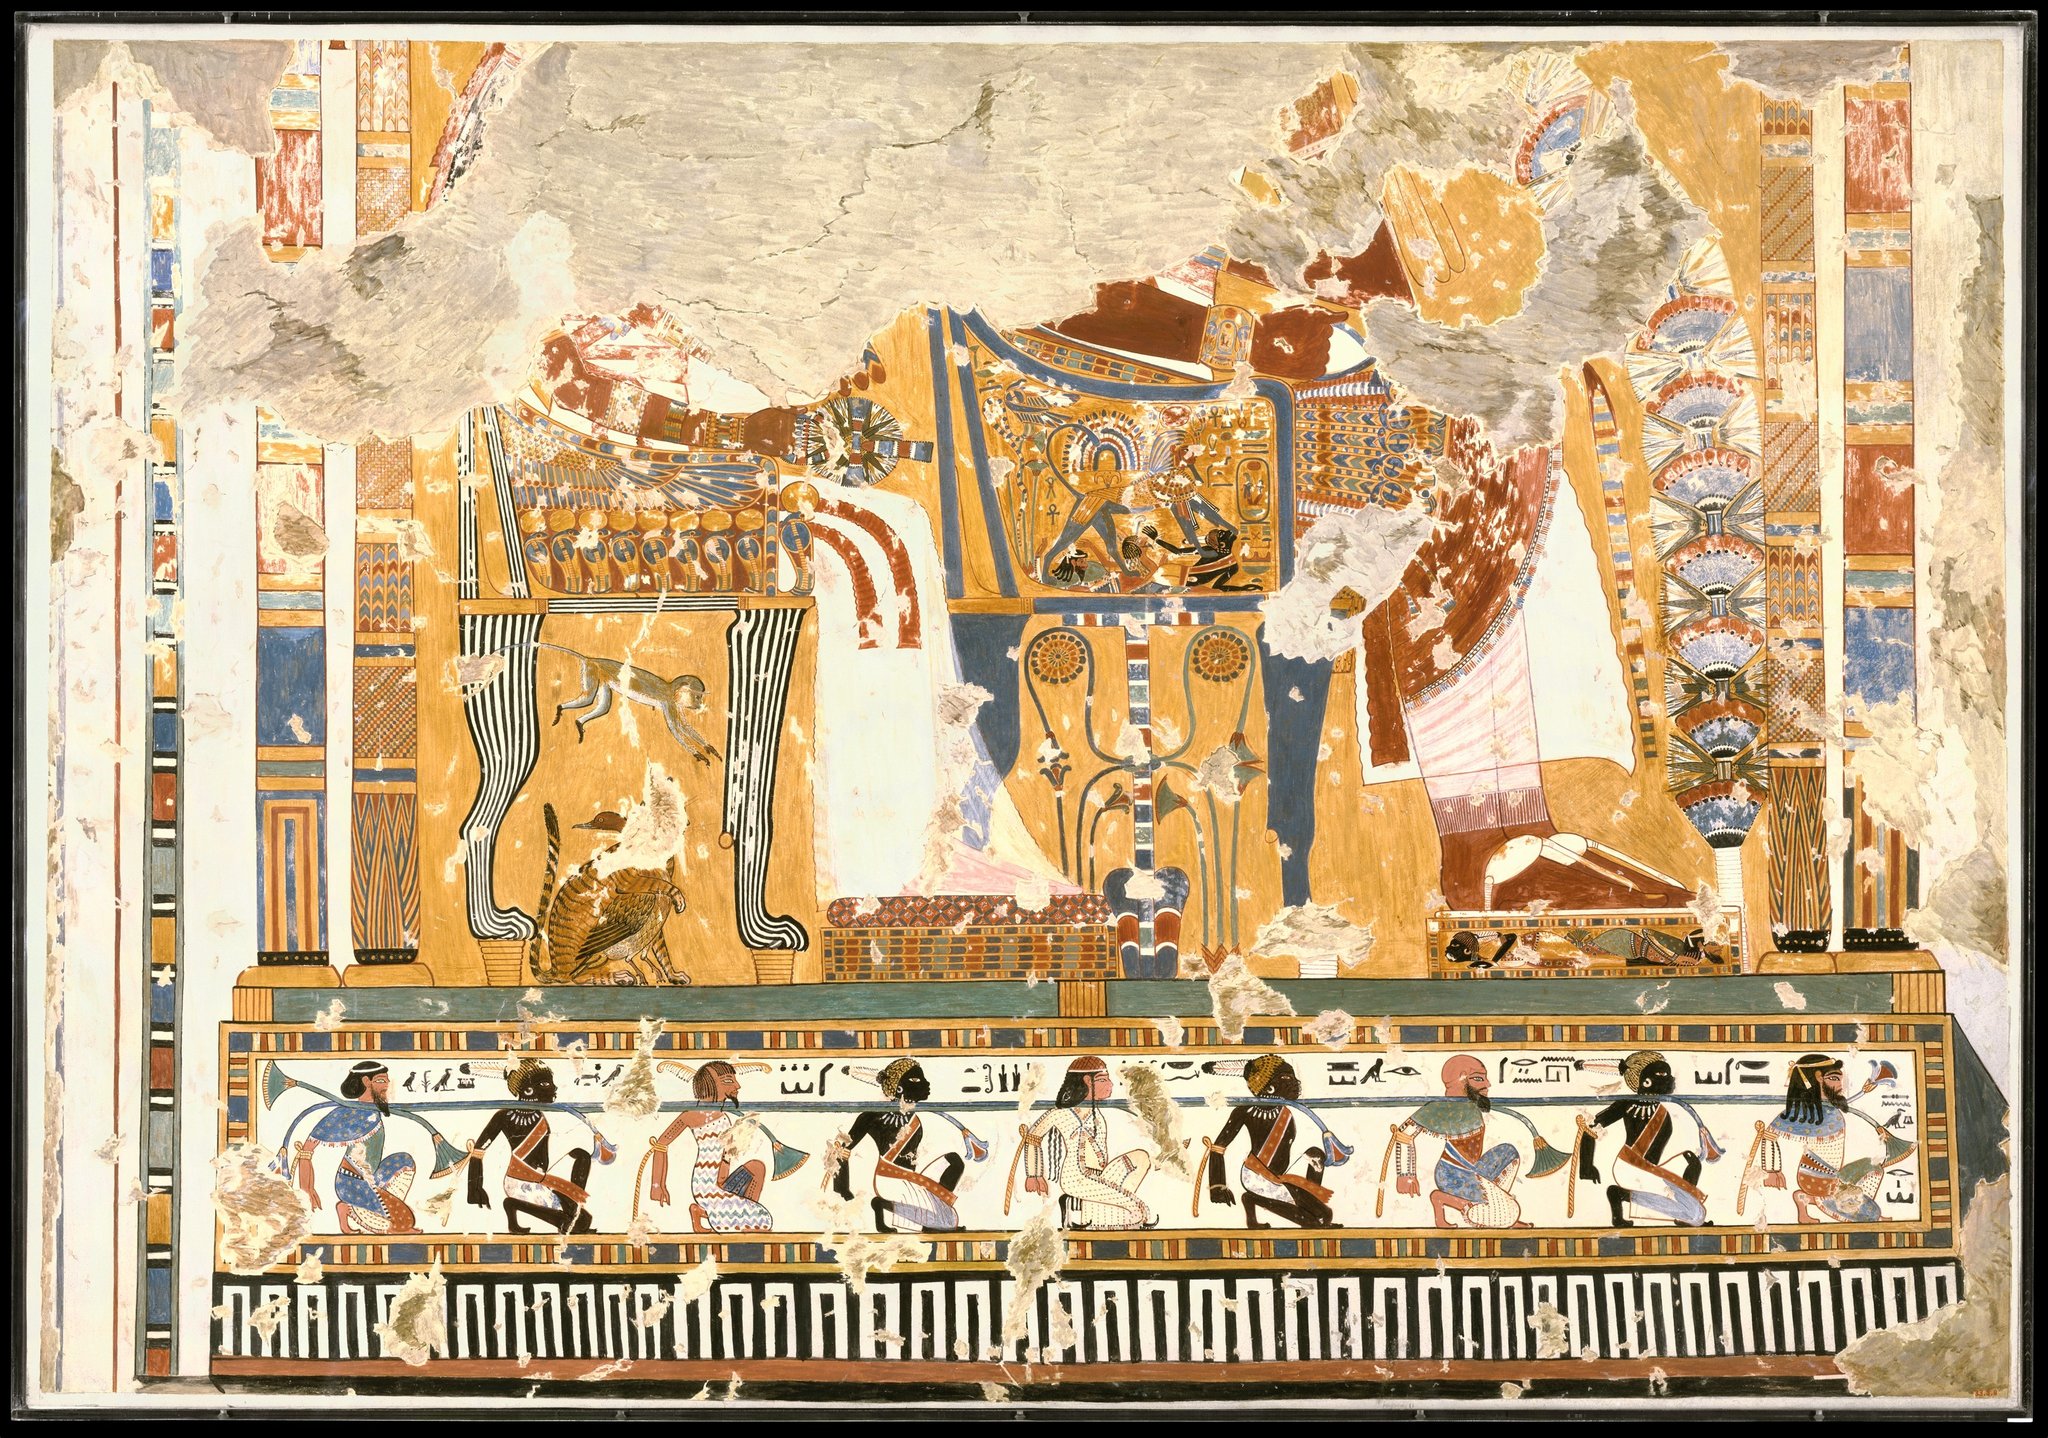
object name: facsimile, anen tt 120, amenhotep iii, queen tiye, kiosk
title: Amenhotep III and Queen Tiye Enthroned Beneath a Kiosk, Tomb of Anen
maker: nina de garis davies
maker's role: artist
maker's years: 1881-1965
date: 1390-1352 BCE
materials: paper, paint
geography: egypt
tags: animals,queens,men,thrones,walk-like-egyptian